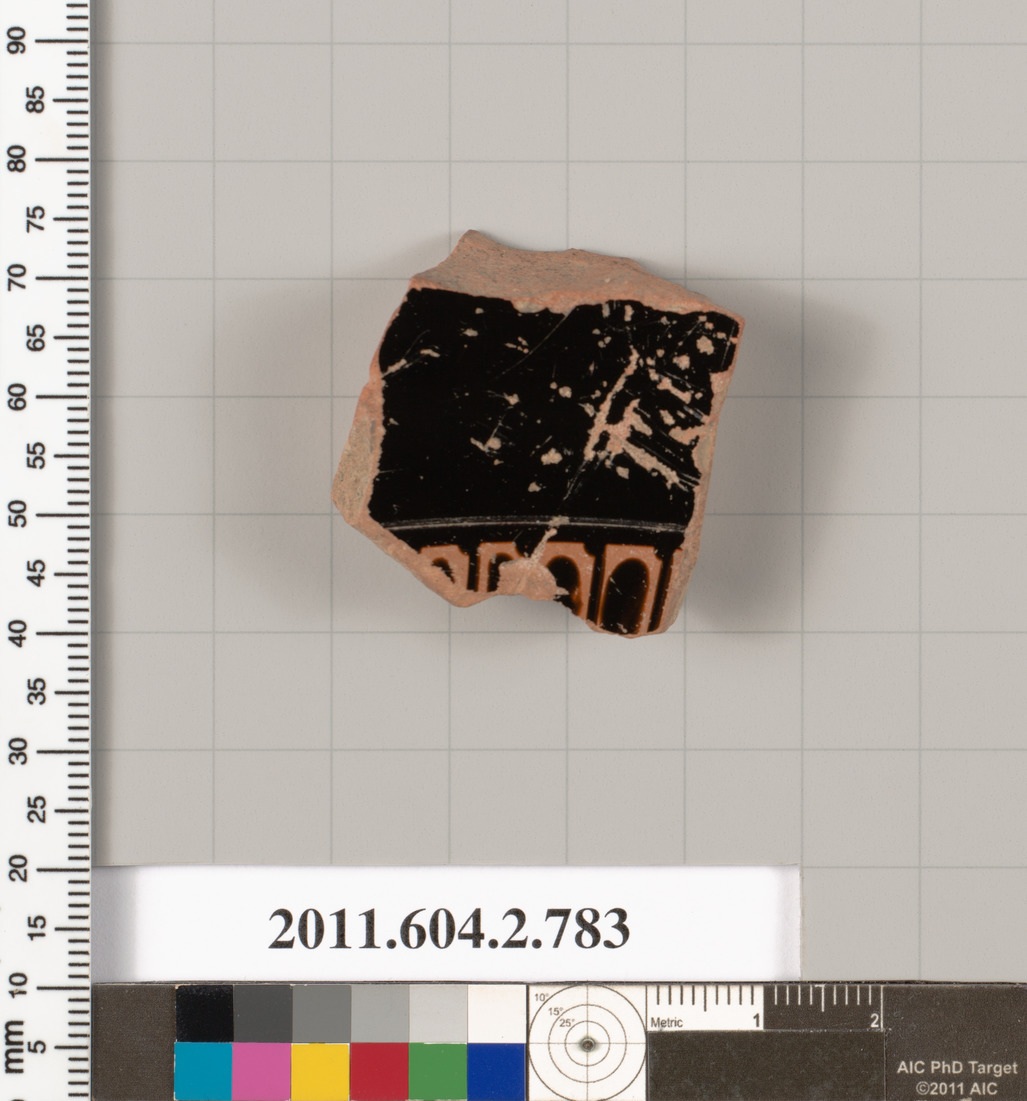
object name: calyx krater fragment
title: Terracotta fragment of a calyx-krater (bowl for mixing wine and water)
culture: greek, attic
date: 475-451 BCE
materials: terracotta